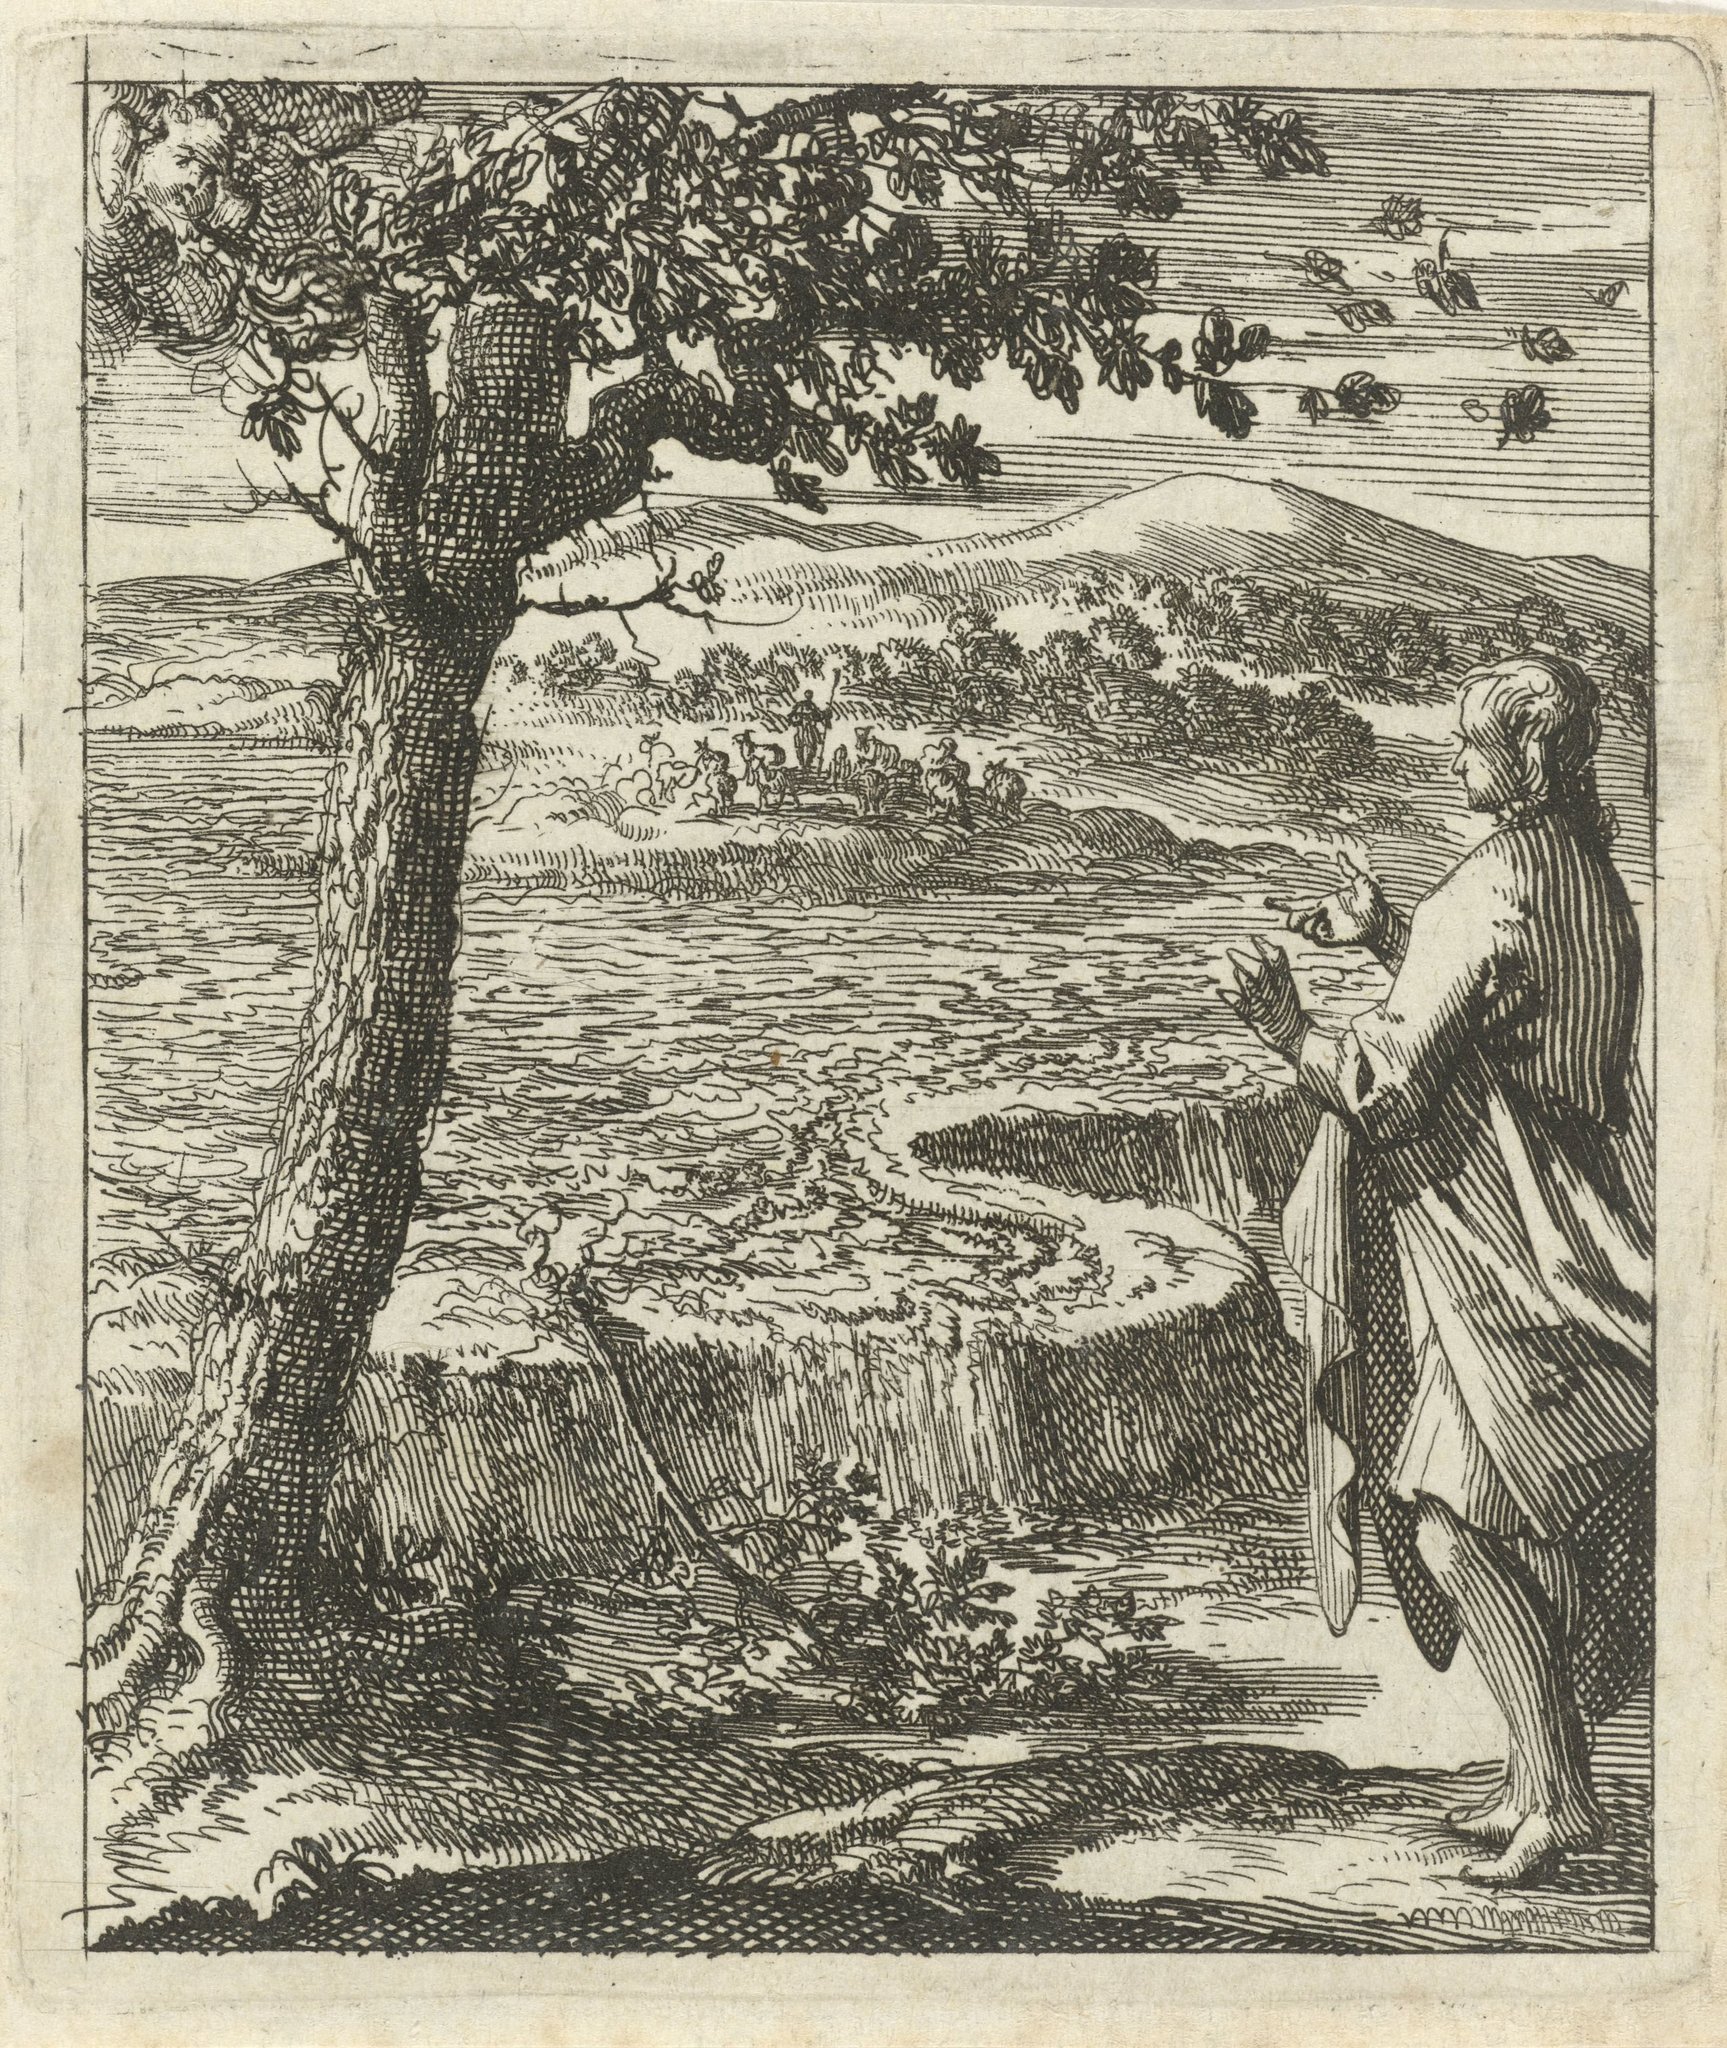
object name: book illustration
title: Jonk en teer, licht om veer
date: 1689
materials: paper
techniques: etching, letterpress printing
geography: amsterdam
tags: dike-break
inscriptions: collector's mark: Lugt 2228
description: Illustratie uit: Huygen, Pieter. De beginselen van Gods koninkryk in den mensch uitgedrukt in zinnebeelden. Amsterdam: wed. Arentsz. Pieter (II), 1689, p. 80.